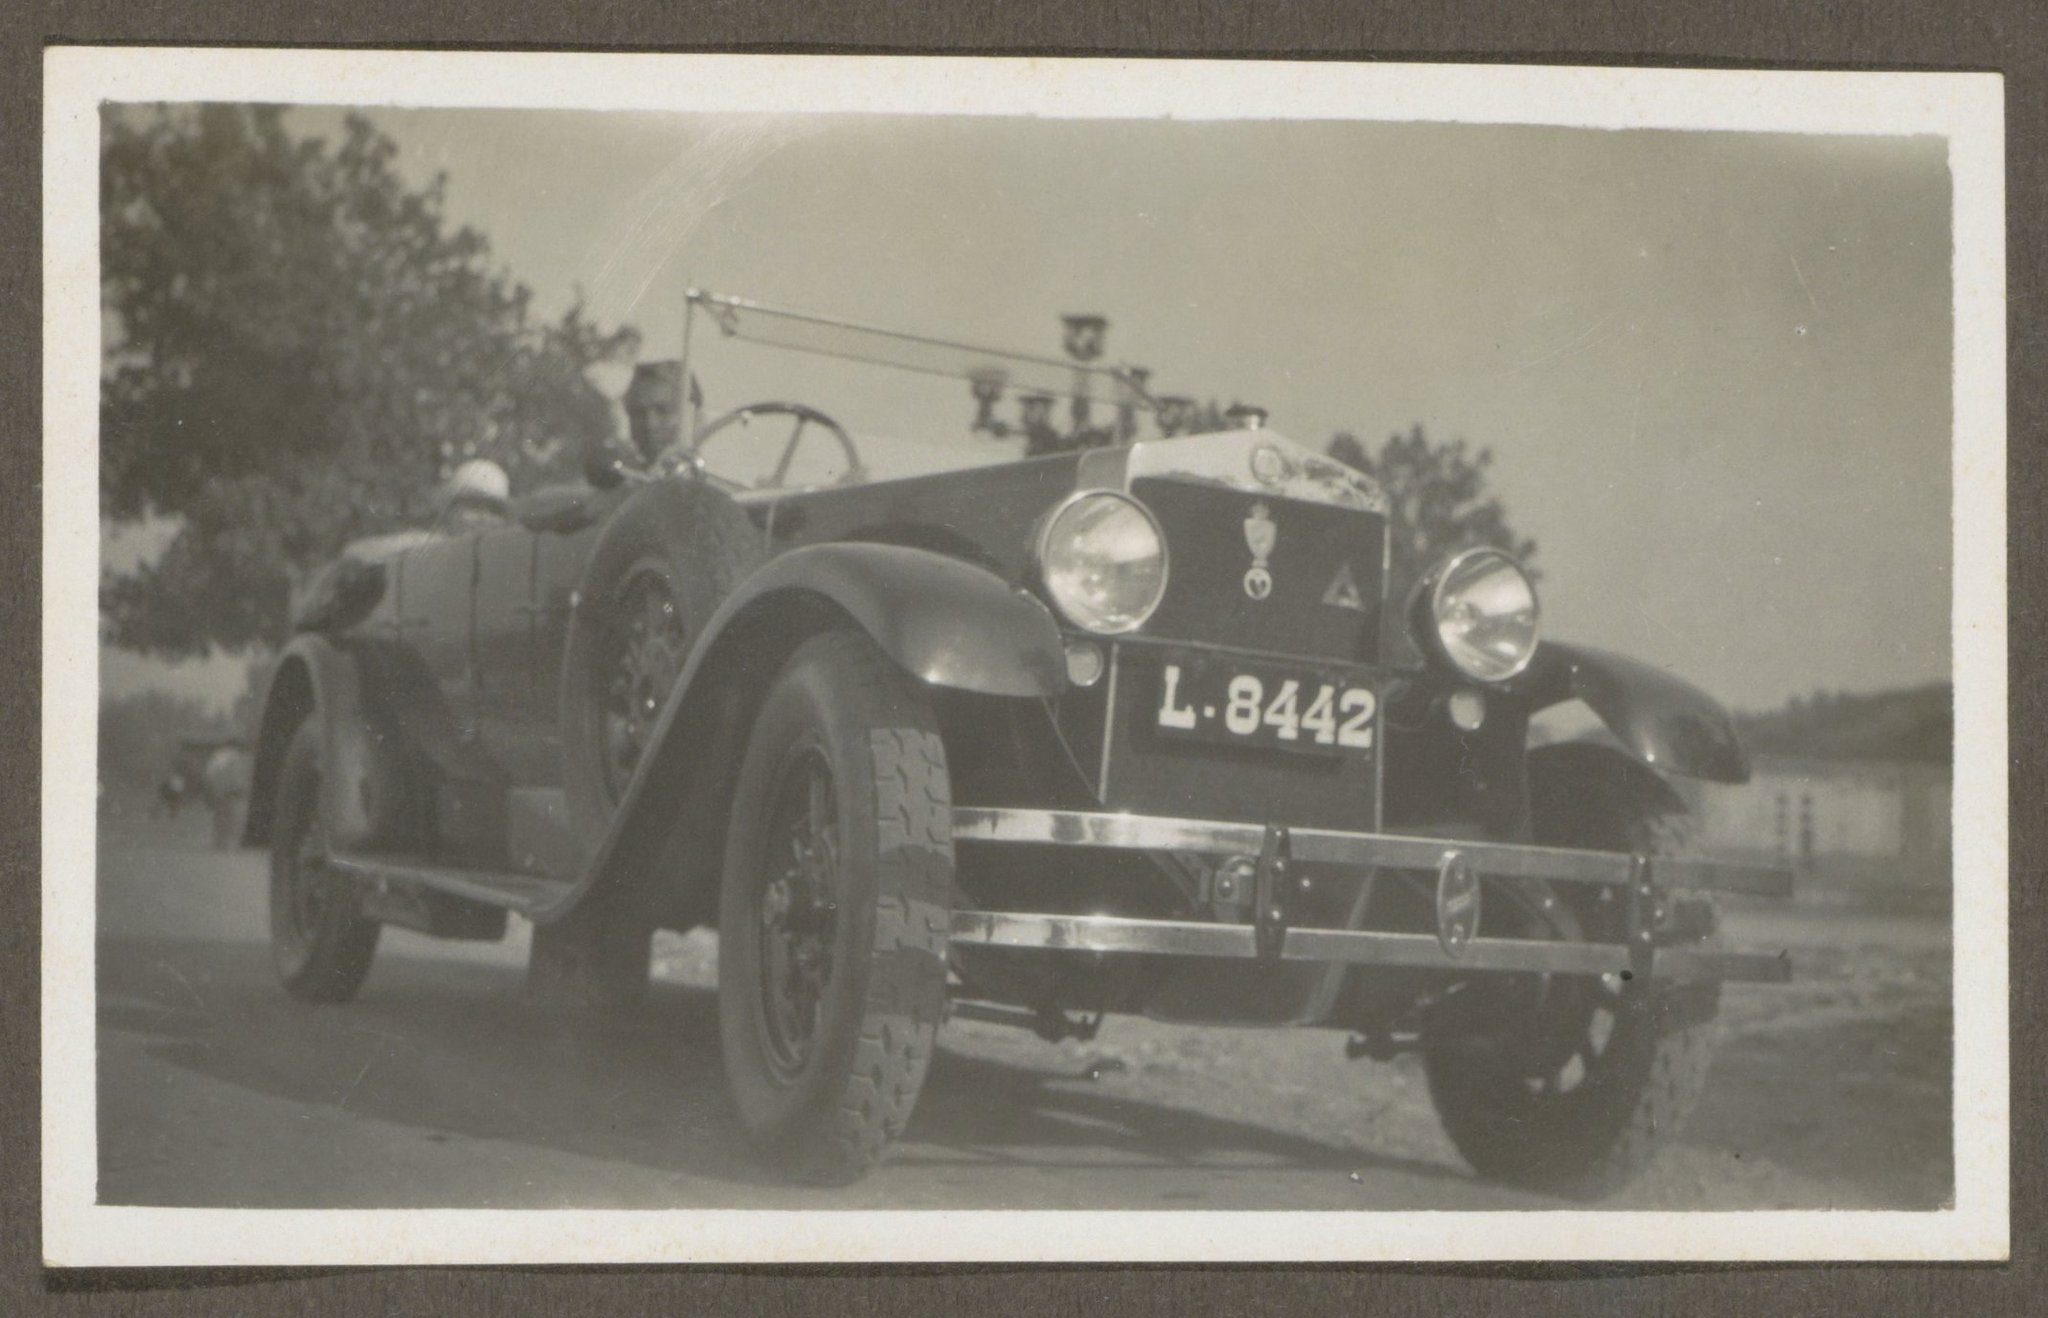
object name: photograph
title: Man achter het stuur van een cabriolet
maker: Anonymous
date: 1920-1930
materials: photographic support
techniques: gelatin silver print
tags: automobile, dutch east indies, the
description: Onderdeel van familiealbum Nederlands-Indië.